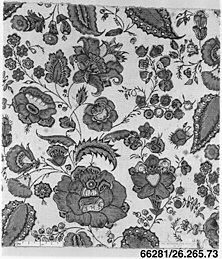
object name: floral print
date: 1734-1766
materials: cotton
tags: flowers